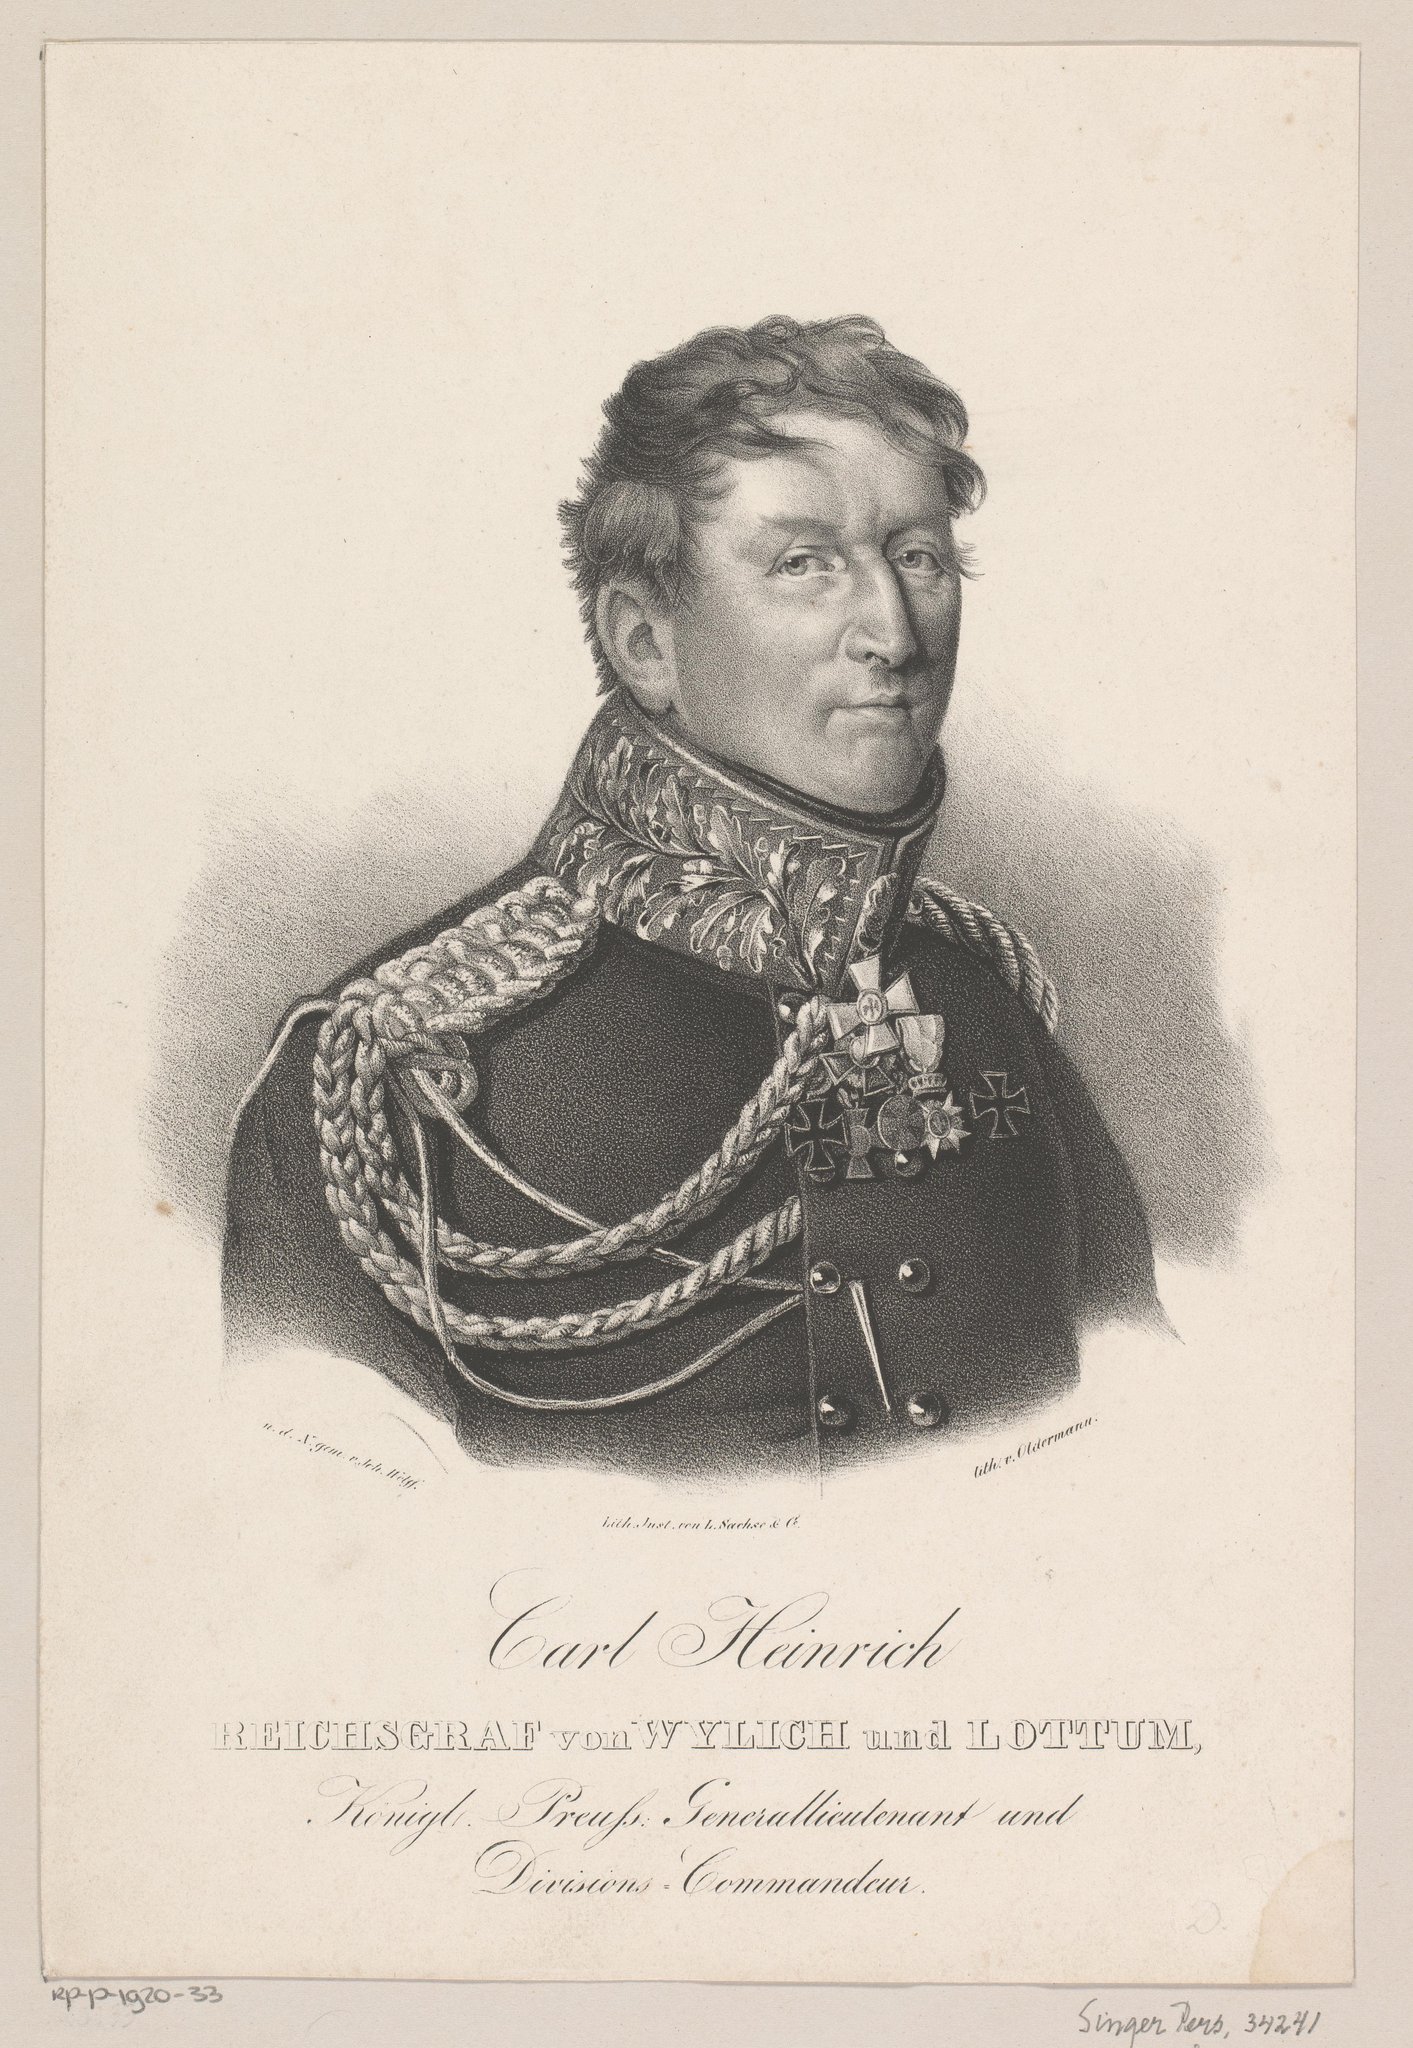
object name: book illustration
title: Portret van Carl Friedrich Heinrich Graf von Wylich und Lottum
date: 1837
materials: paper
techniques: lithograph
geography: germany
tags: berlin, commander-in-chief, general, marshal, historical persons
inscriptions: collector's mark: Lugt 2228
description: Prent waarschijnlijk uit: Genealogisches Taschenbuch der deutschen gräflichen Häuser auf das Jahr 1837. Gotha: Justus Perthes, 1837.